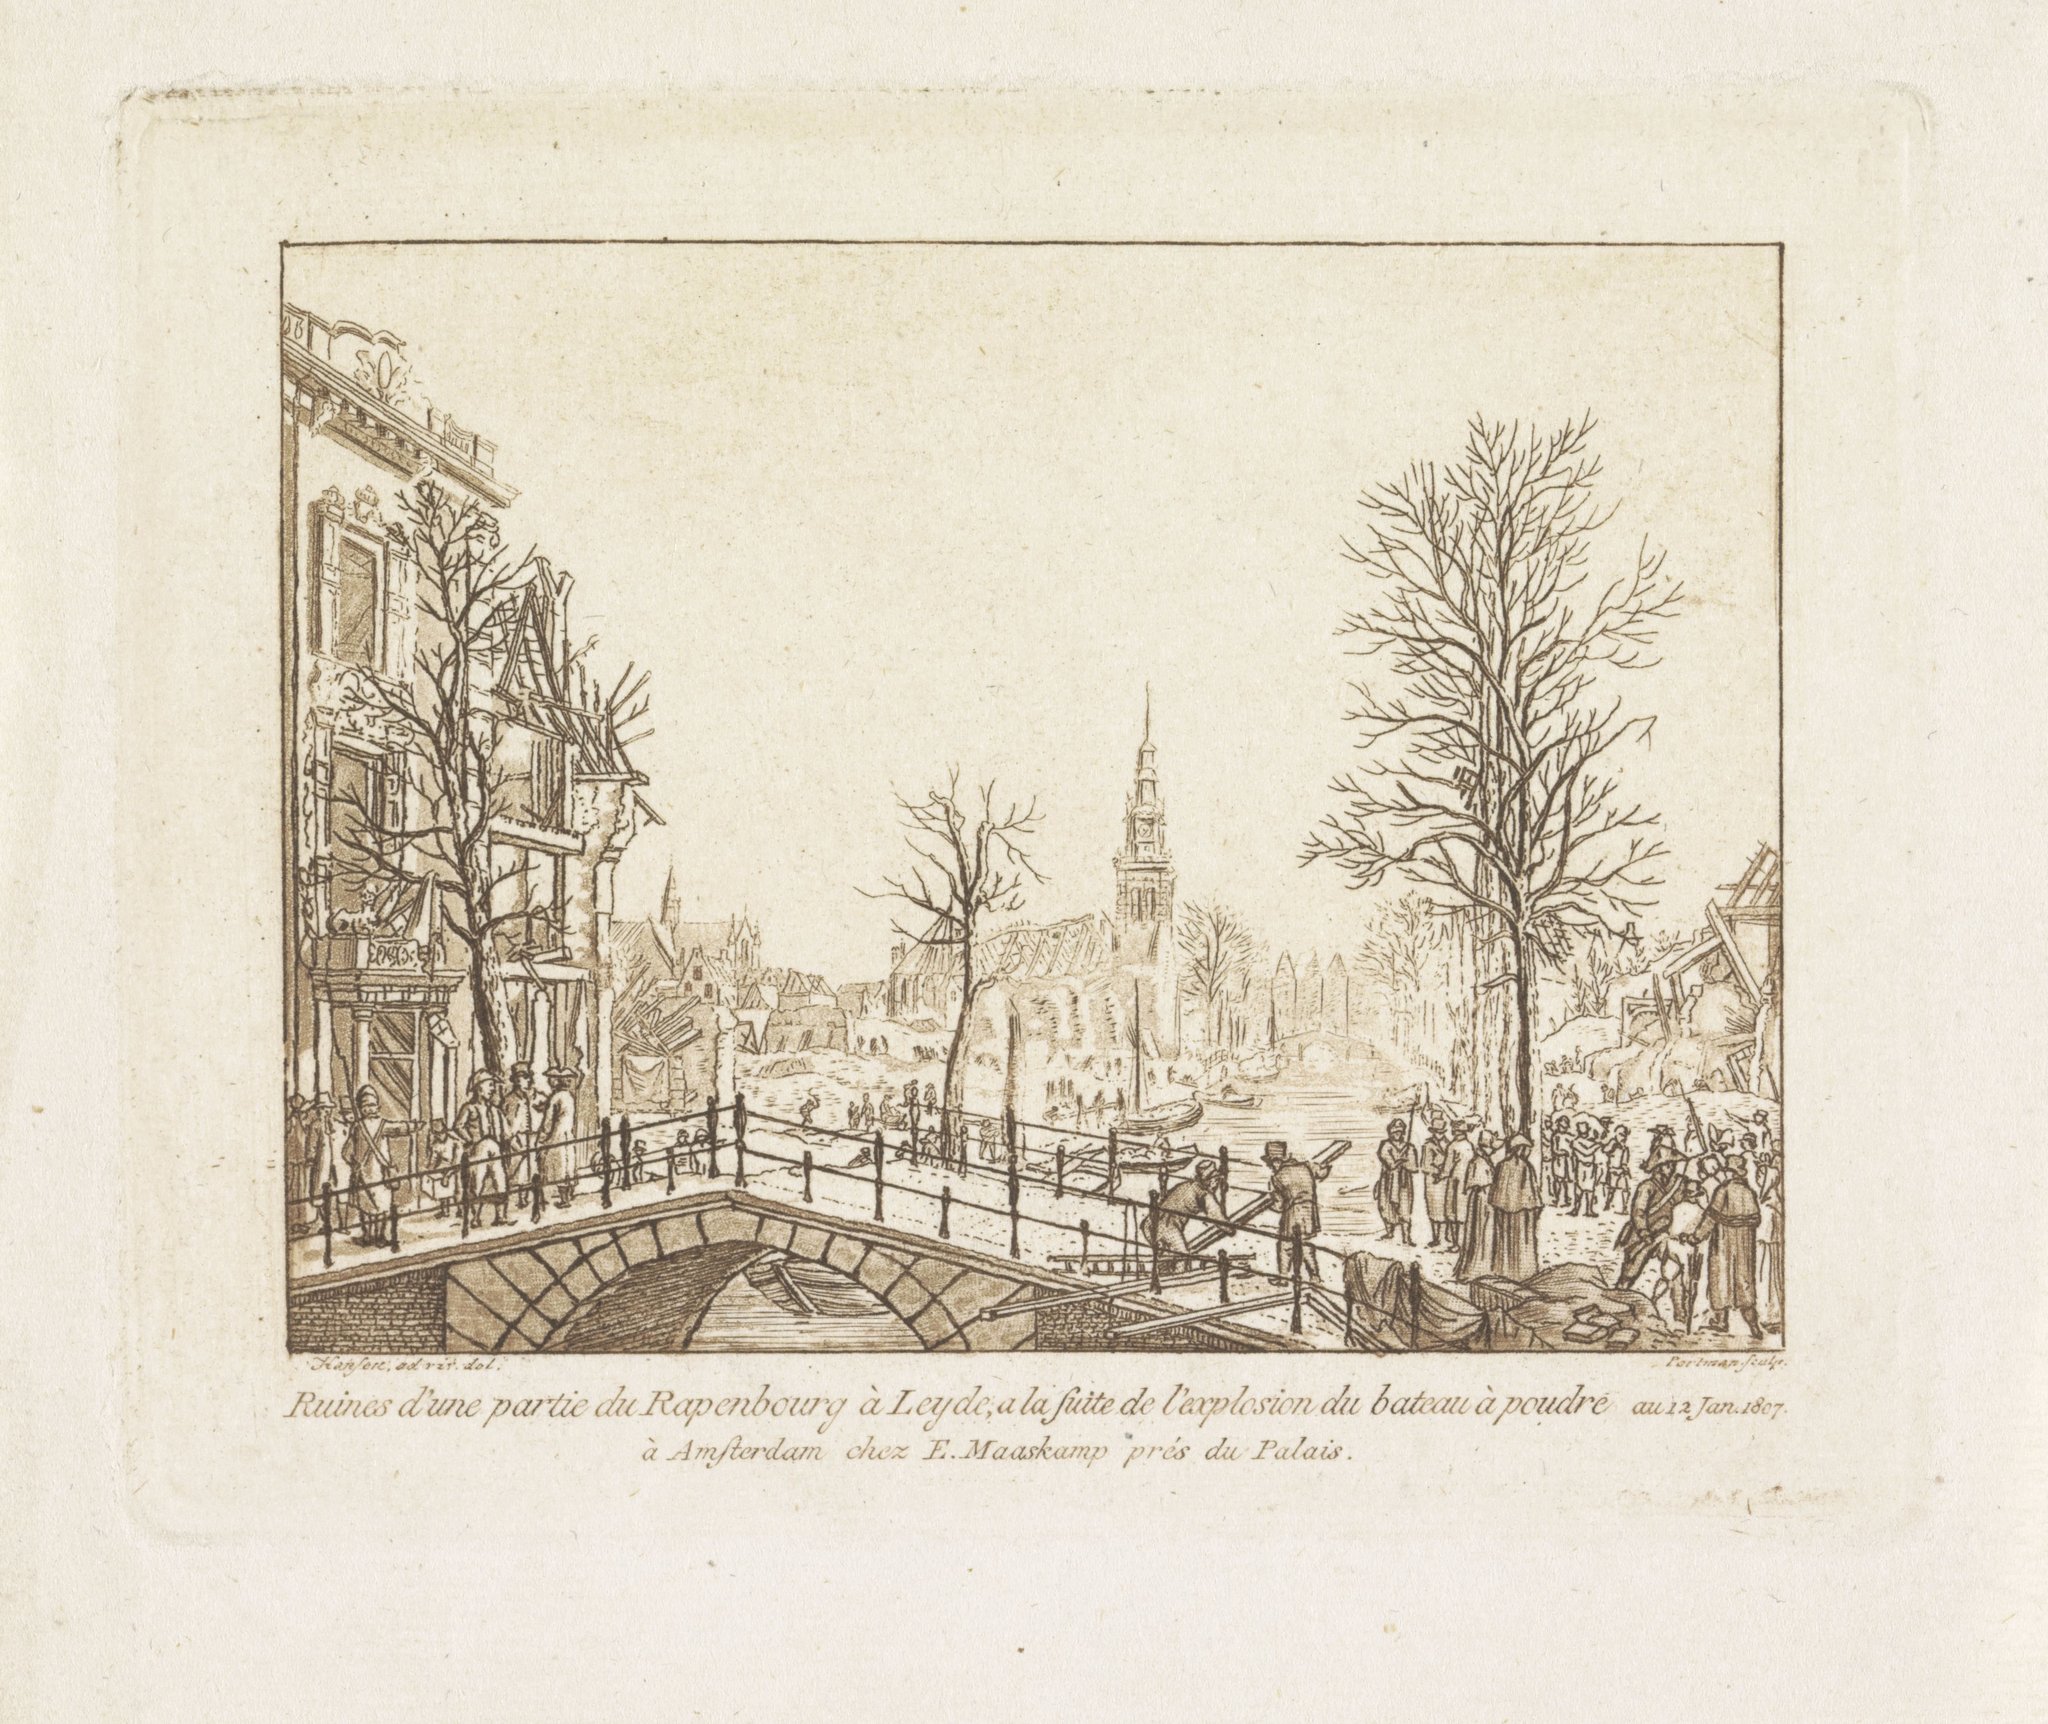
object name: print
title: Ruines d'une part du Rapenbourg à Leyde, a la suite de l'explosion du bateau à poudre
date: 1816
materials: paper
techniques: aquatint, etching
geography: amsterdam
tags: gunpowder disaster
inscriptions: collector's mark: Lugt 2228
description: Gebruikt als illustratie in: Merkwaardige gezigten, gebouwen, monumenten en standbeelden in de Noordelijke provintiën van het Koningrijk der Nederlanden = Vues remarquables, édifices, monumens et statues dans les provinces septentrionales du Royaume des Pays-Bas. Amsterdam: Evert Maaskamp, 1816.